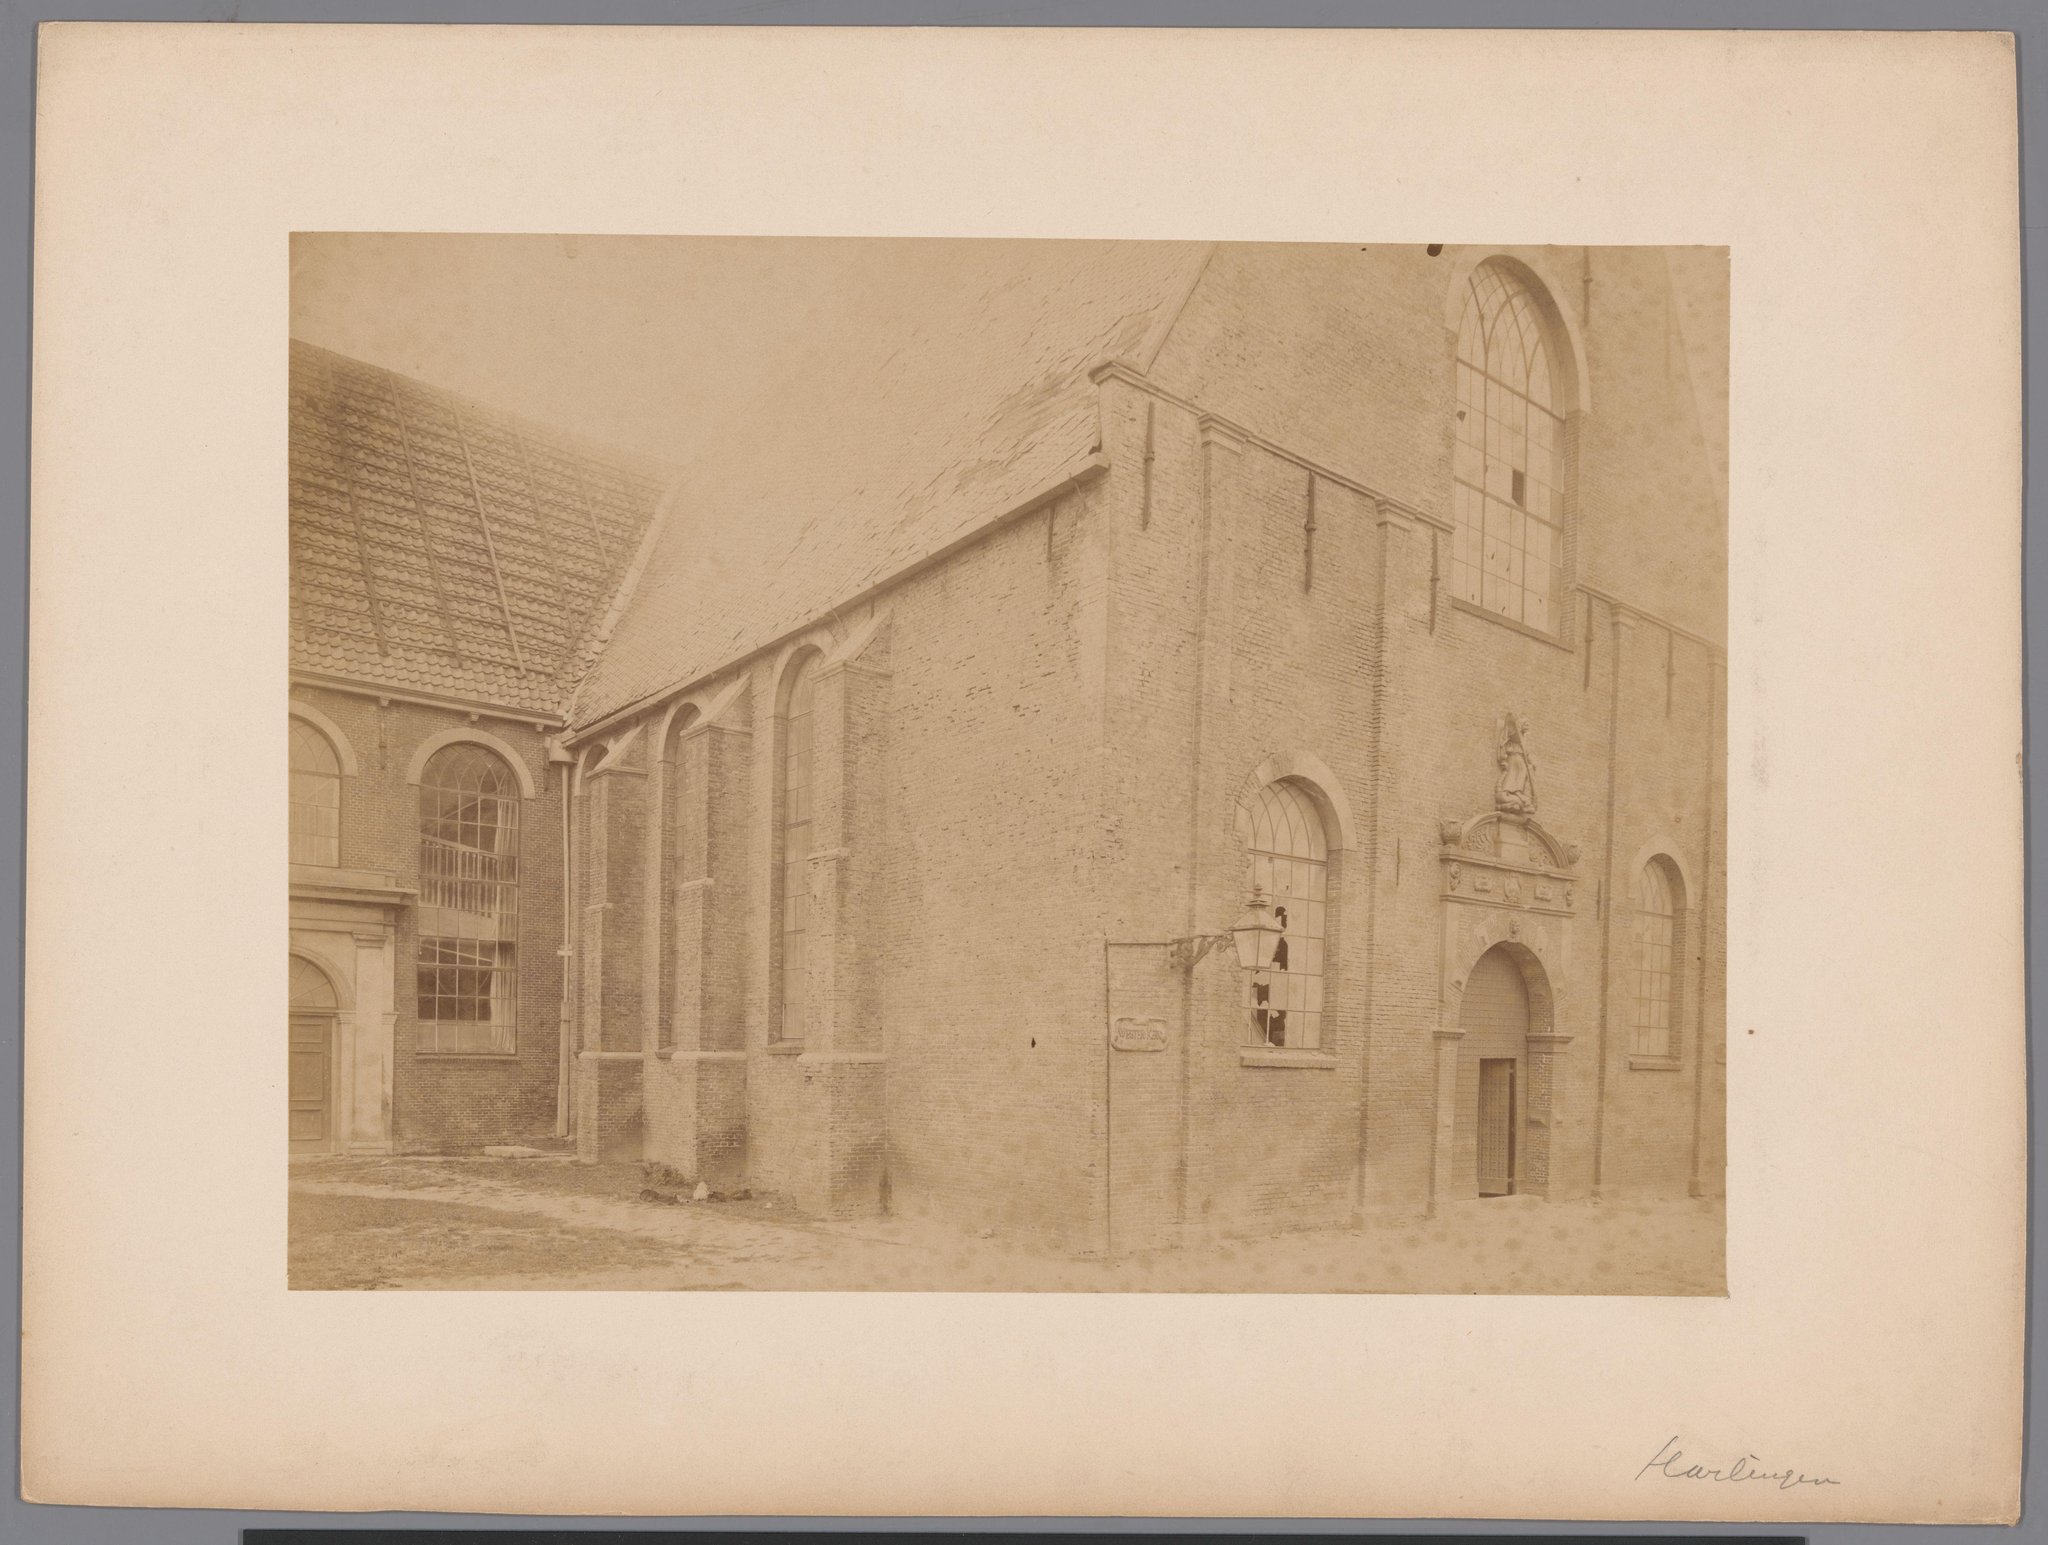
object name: photograph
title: Westerkerk te Harlingen, kort voor de afbraak in 1896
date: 1896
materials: cardboard, photographic support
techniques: albumen print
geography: harlingen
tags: church (exterior), harlingen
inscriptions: annotation: ‘Westerkerk te Harlingen (Fr) / Julij 1896’, annotation: ‘Harlingen’